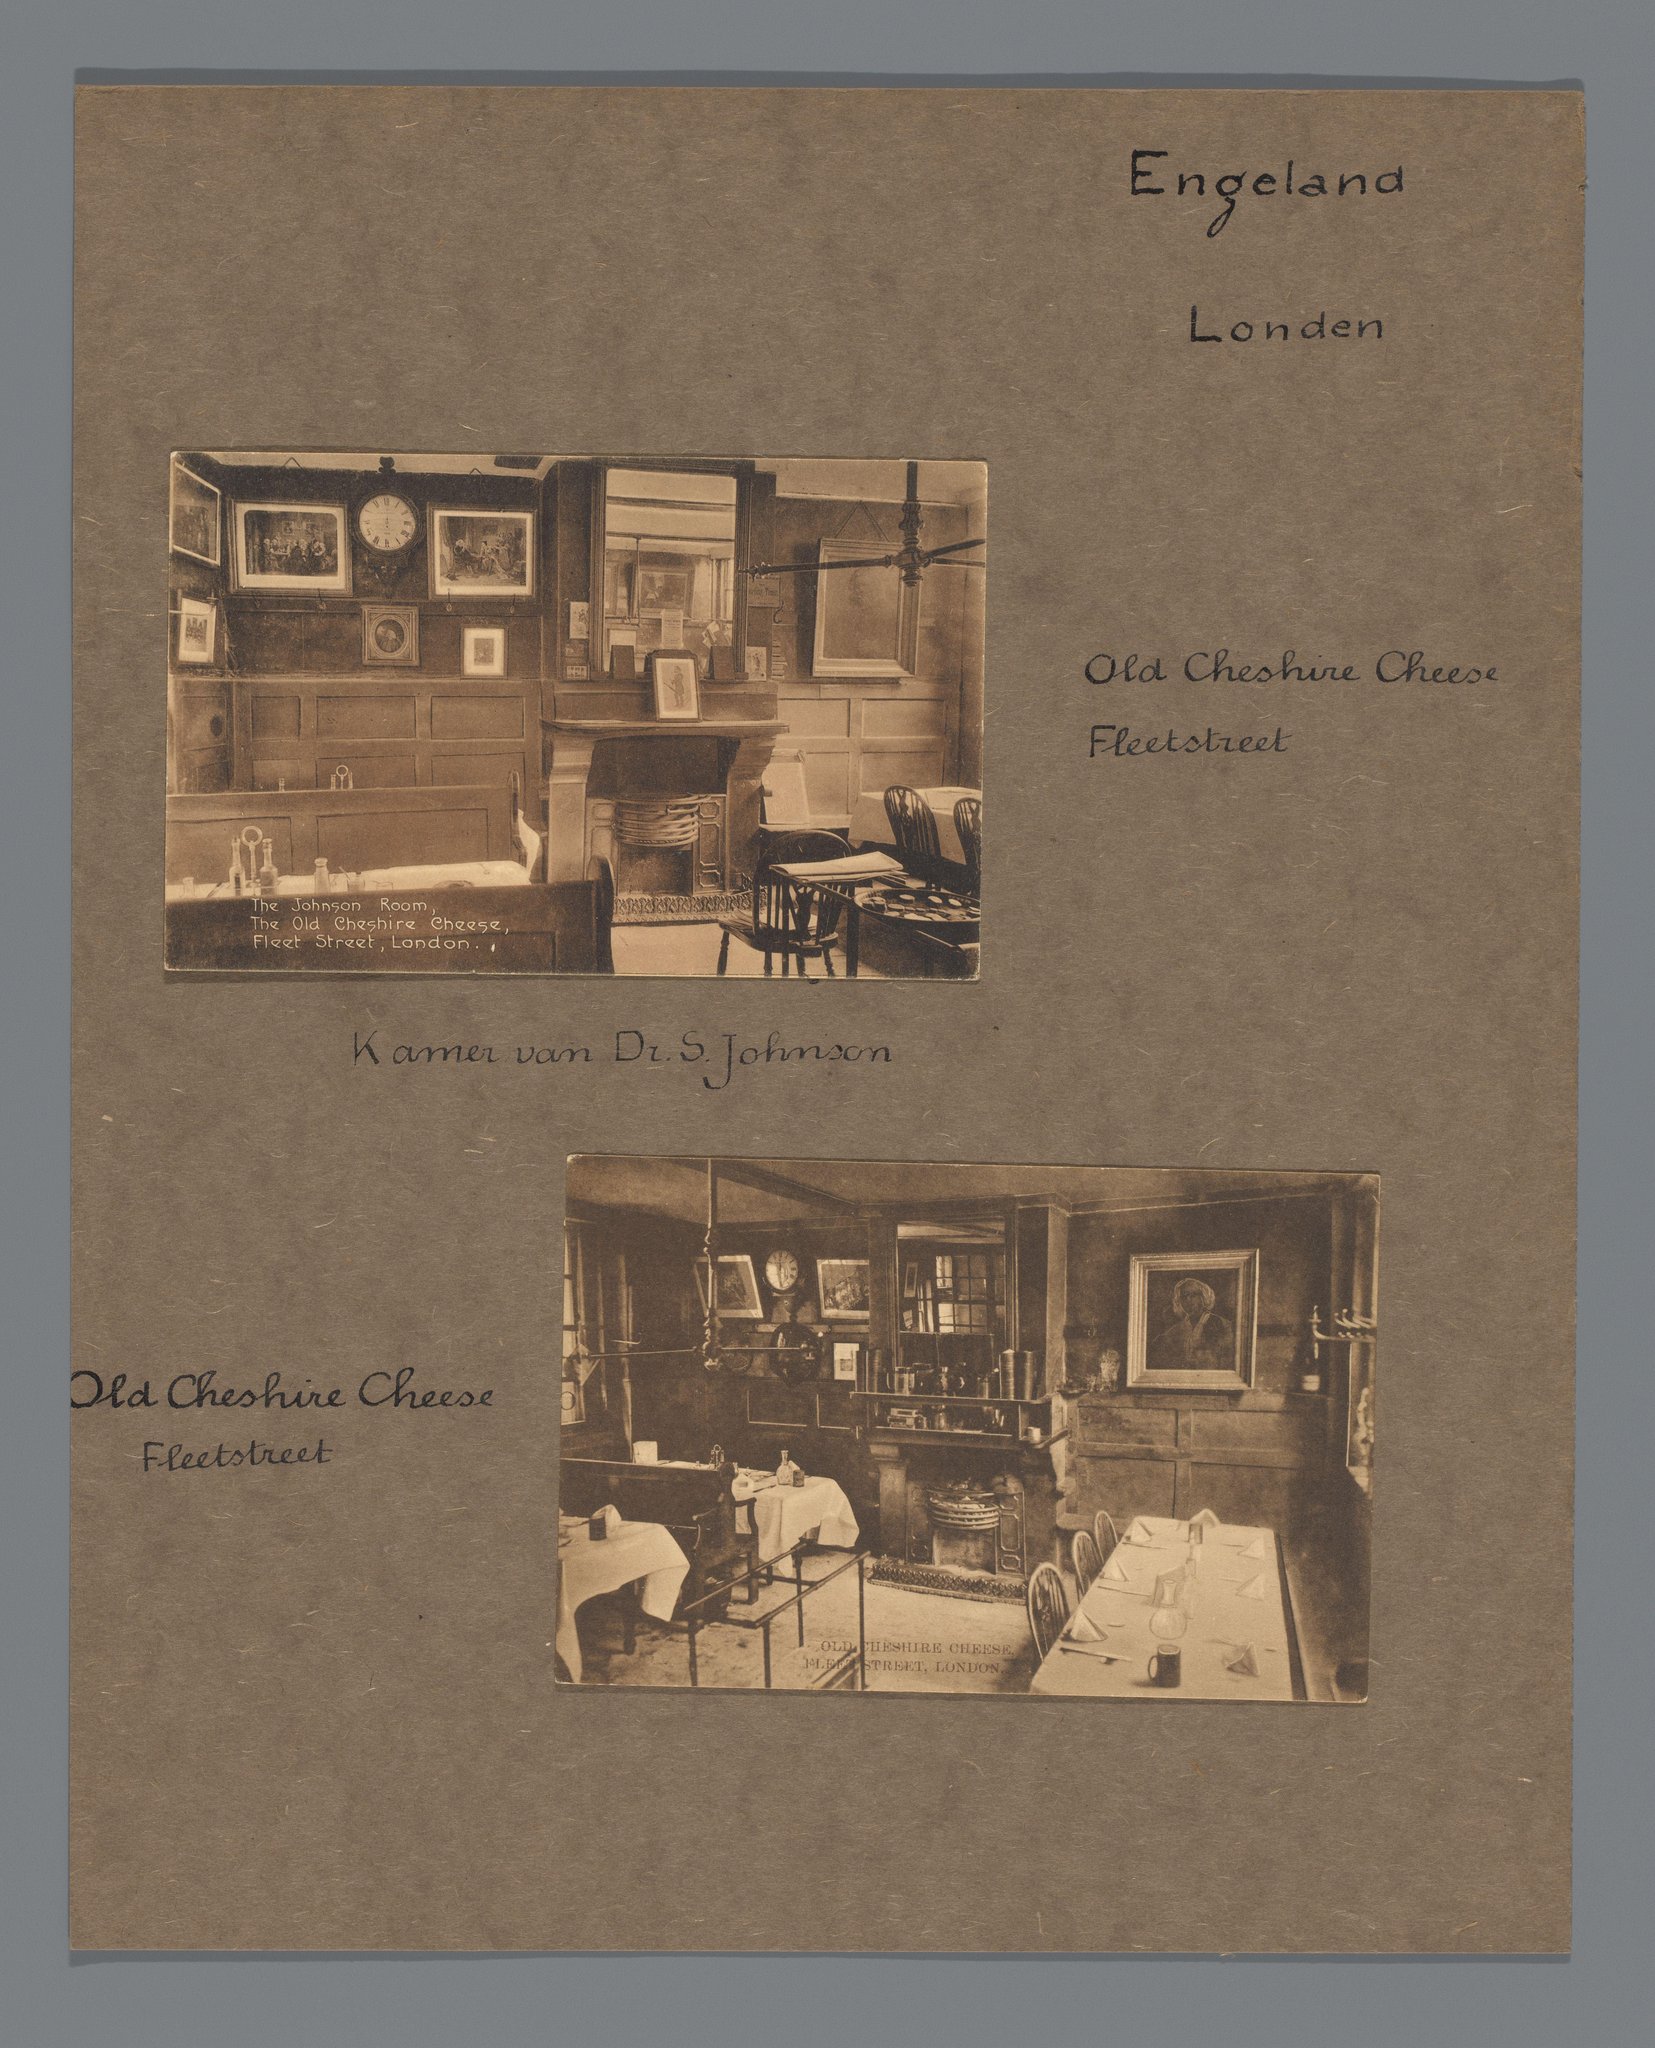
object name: photograph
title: Londen. Huizen. Old Cheshire Cheese Fleetstreet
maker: Anonymous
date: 1860-1925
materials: photographic support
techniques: photograph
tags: fleet street